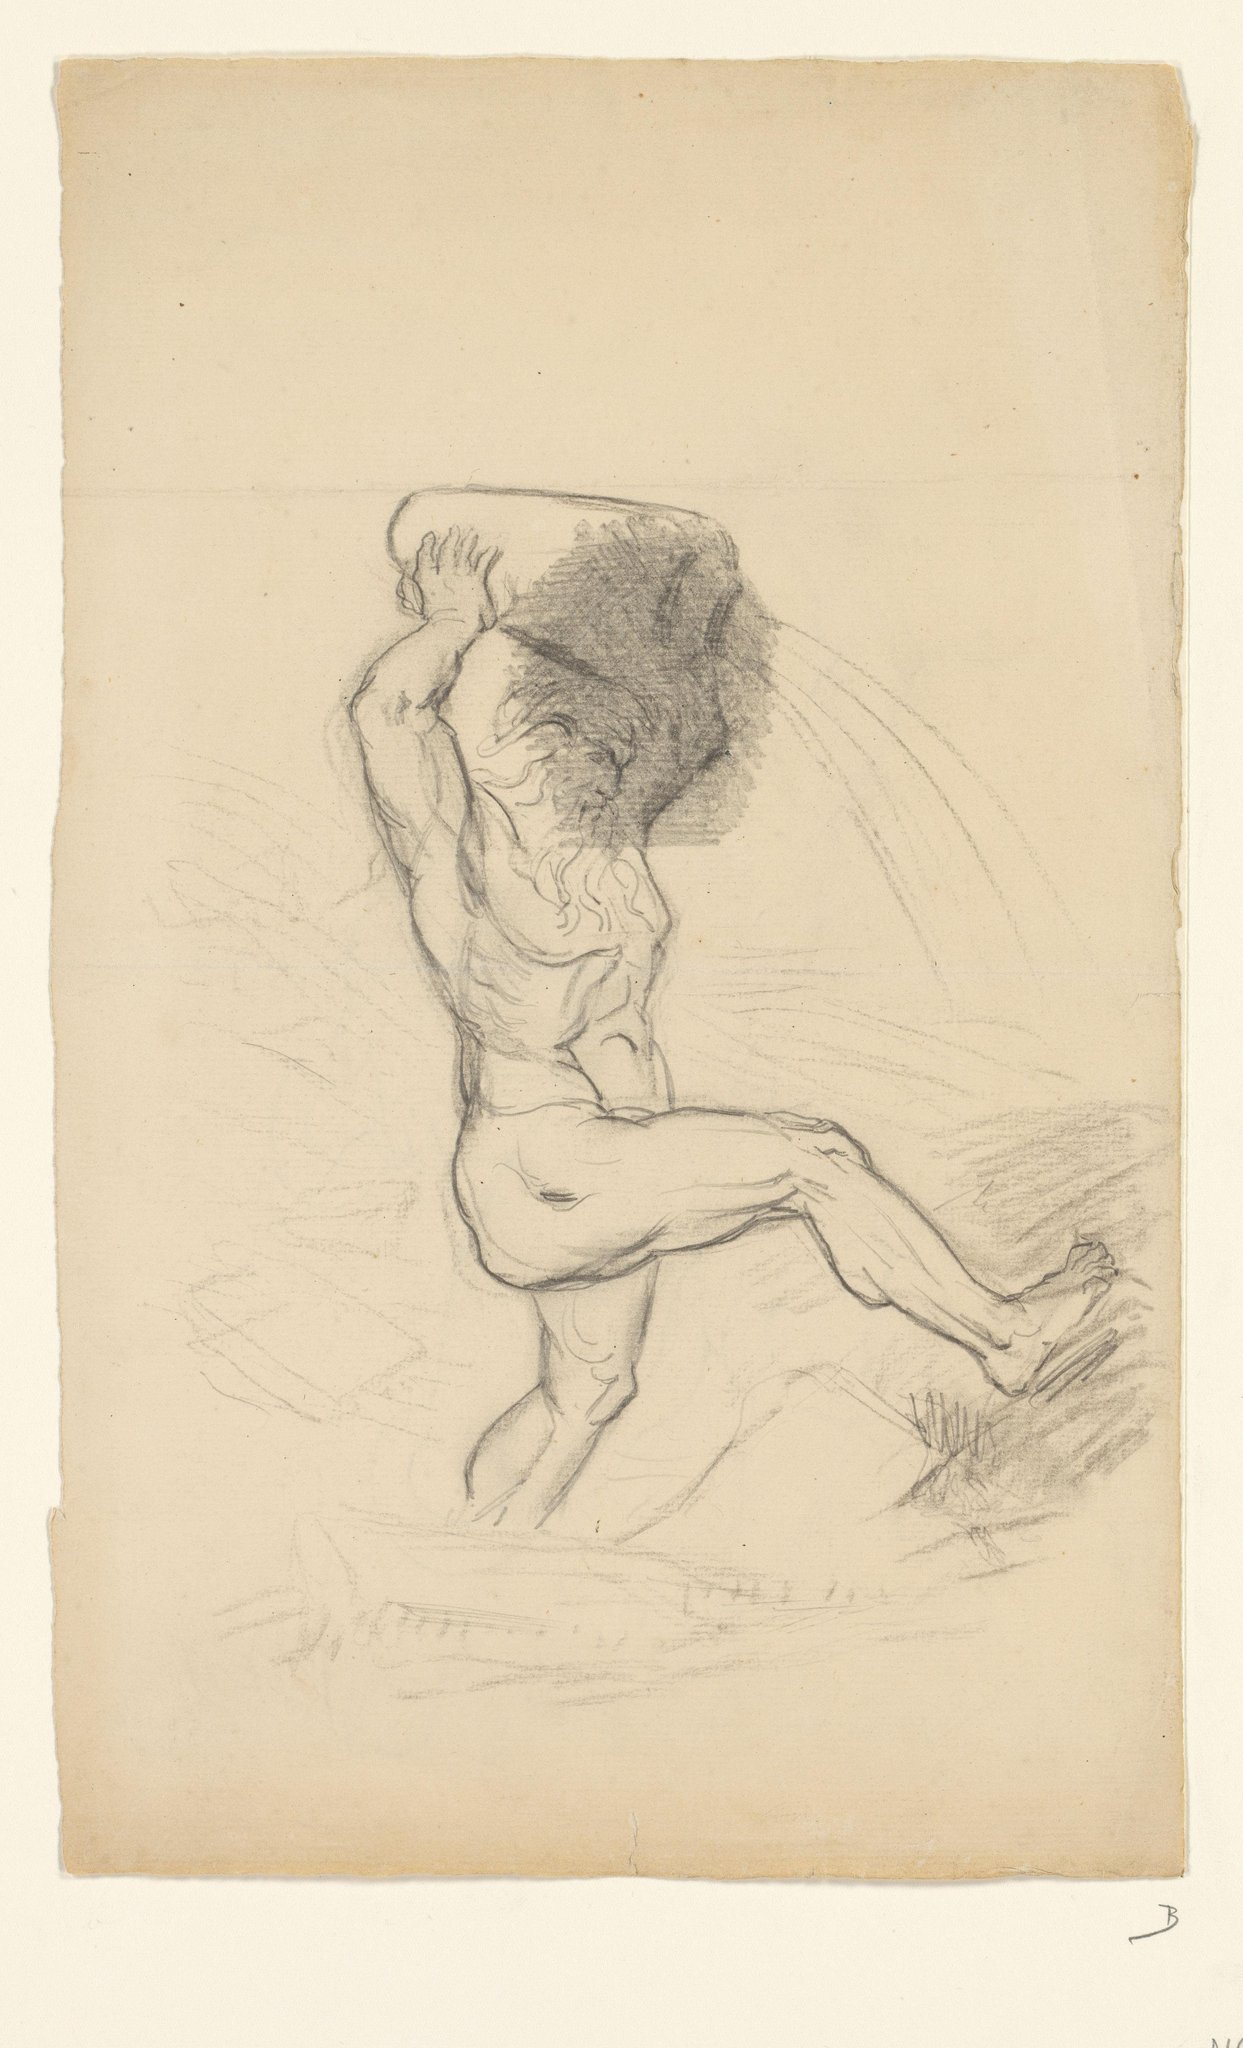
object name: preparatory study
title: Bebaarde man stort kruik leeg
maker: johan michaël schmidt crans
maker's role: draughtsman, print maker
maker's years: 1830-1907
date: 1880-1890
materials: chalk, paper, pencil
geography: netherlands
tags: political caricatures and satires, netherlands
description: Bebaarde man giet een kruik boven zijn hoofd leeg terwijl hij met zijn rechterbeen iets stuk lijkt te trappen. Mogelijk watersnood door een doorgedraaide riviergod. Waarschijnlijk een schets voor een spotprent in De Nederlandsche Spectator.